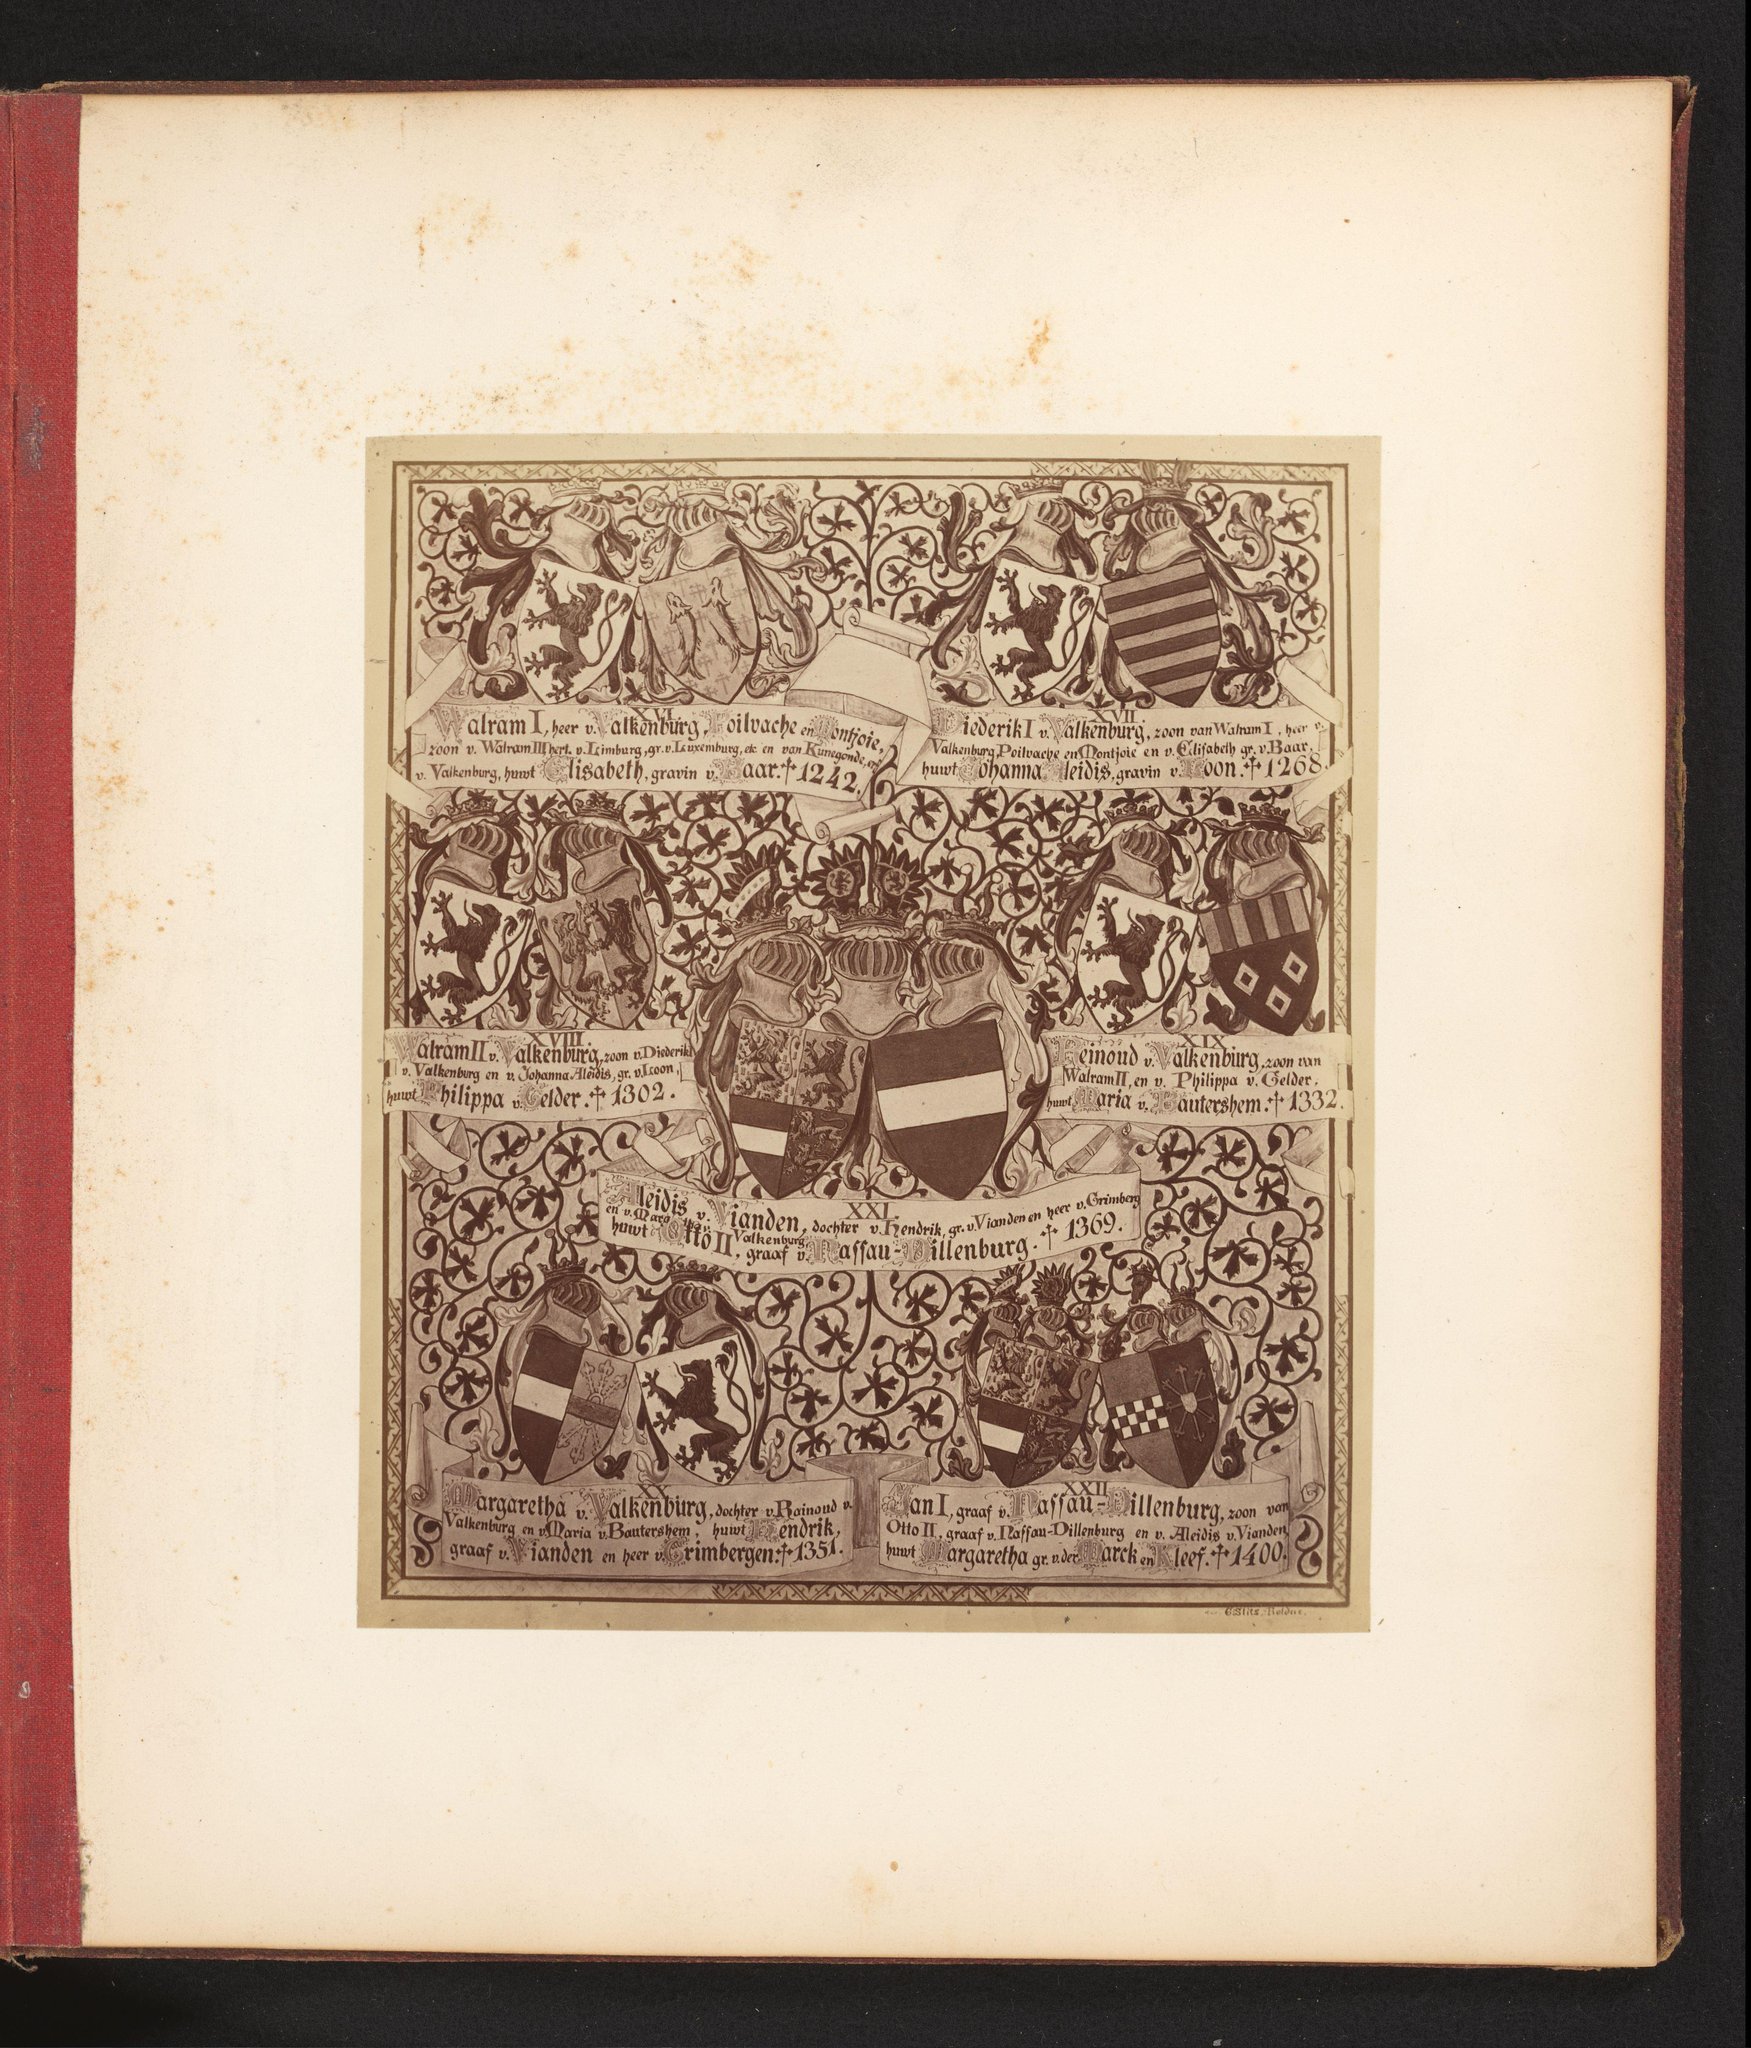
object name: photograph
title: Fotoreproductie van een tekening van een stamboom, van Walram I, heer van Valkenburg, tot Jan I, graaf van Nassau-Dillenburg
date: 1869-1874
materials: cardboard, paper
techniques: albumen print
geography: rolduc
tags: family lineage, pedigree, genealogical tree or table, series of rulers